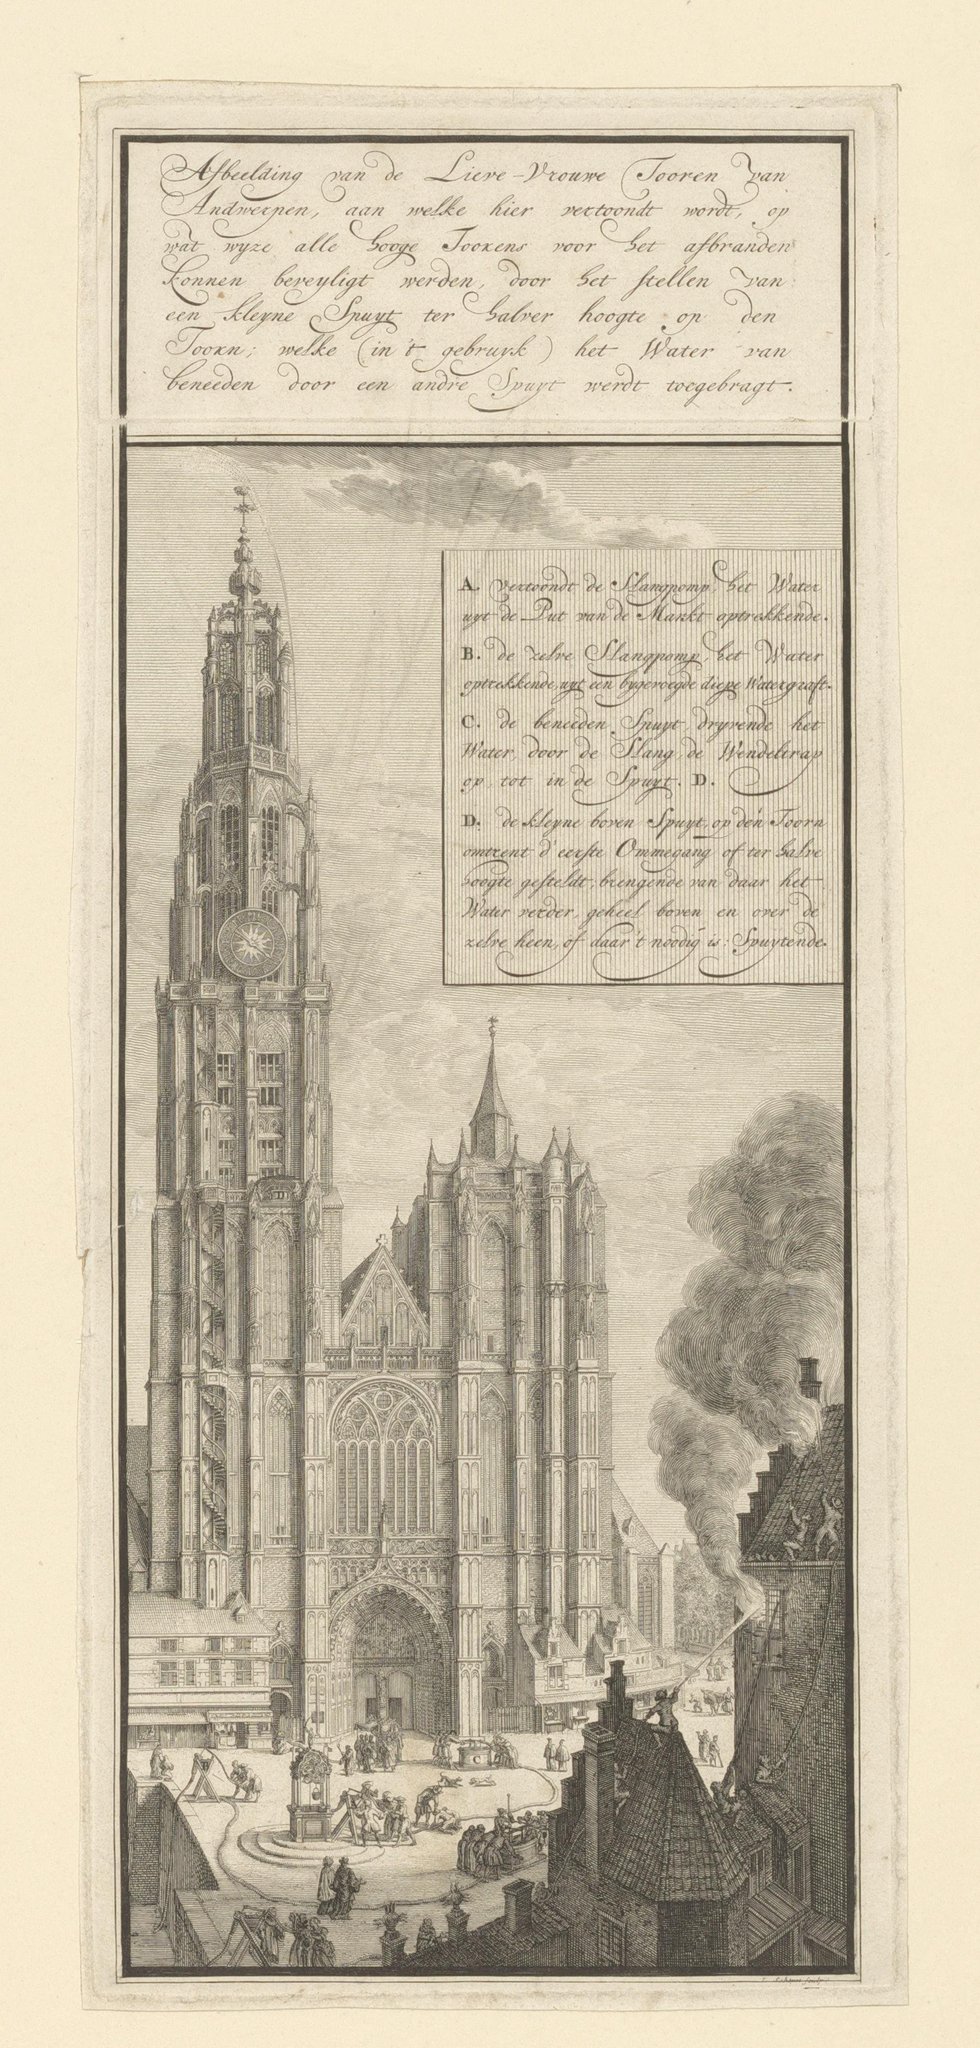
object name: print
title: Demonstratie van de slangbrandspuiten op de toren van de Onze-Lieve-Vrouwekathedraal te Antwerpen, ca. 1670-1680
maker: laurens scherm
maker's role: draughtsman, print maker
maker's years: 1671-1702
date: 1735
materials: paper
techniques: engraving, etching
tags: on fire, ablaze, roman catholic church, pump (fire-extinguishing equipment)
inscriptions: stamp, collector's mark: Lugt 1641, stamp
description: Demonstratie van het gebruik van de slangbrandspuiten door het oppompen van water uit een put en over de toren van de Onze-Lieve-Vrouwekathedraal te Antwerpen heen te spuiten (ca. 1670-1680). Op de voorgrond het blussen van een brand in een huis aan het plein. In een cartouche de verklaring van de letters A-D in het Nederlands. Boven de plaat is een tweede plaat met tekst afgedrukt. Plaat 25 in de herdruk van het Brandspuitenboek van Jan van der Heyden uit 1735. Onderwerpsrubrieken binnen de Atlas Zeden en Gewoonten: Regeering, Brandwezen.